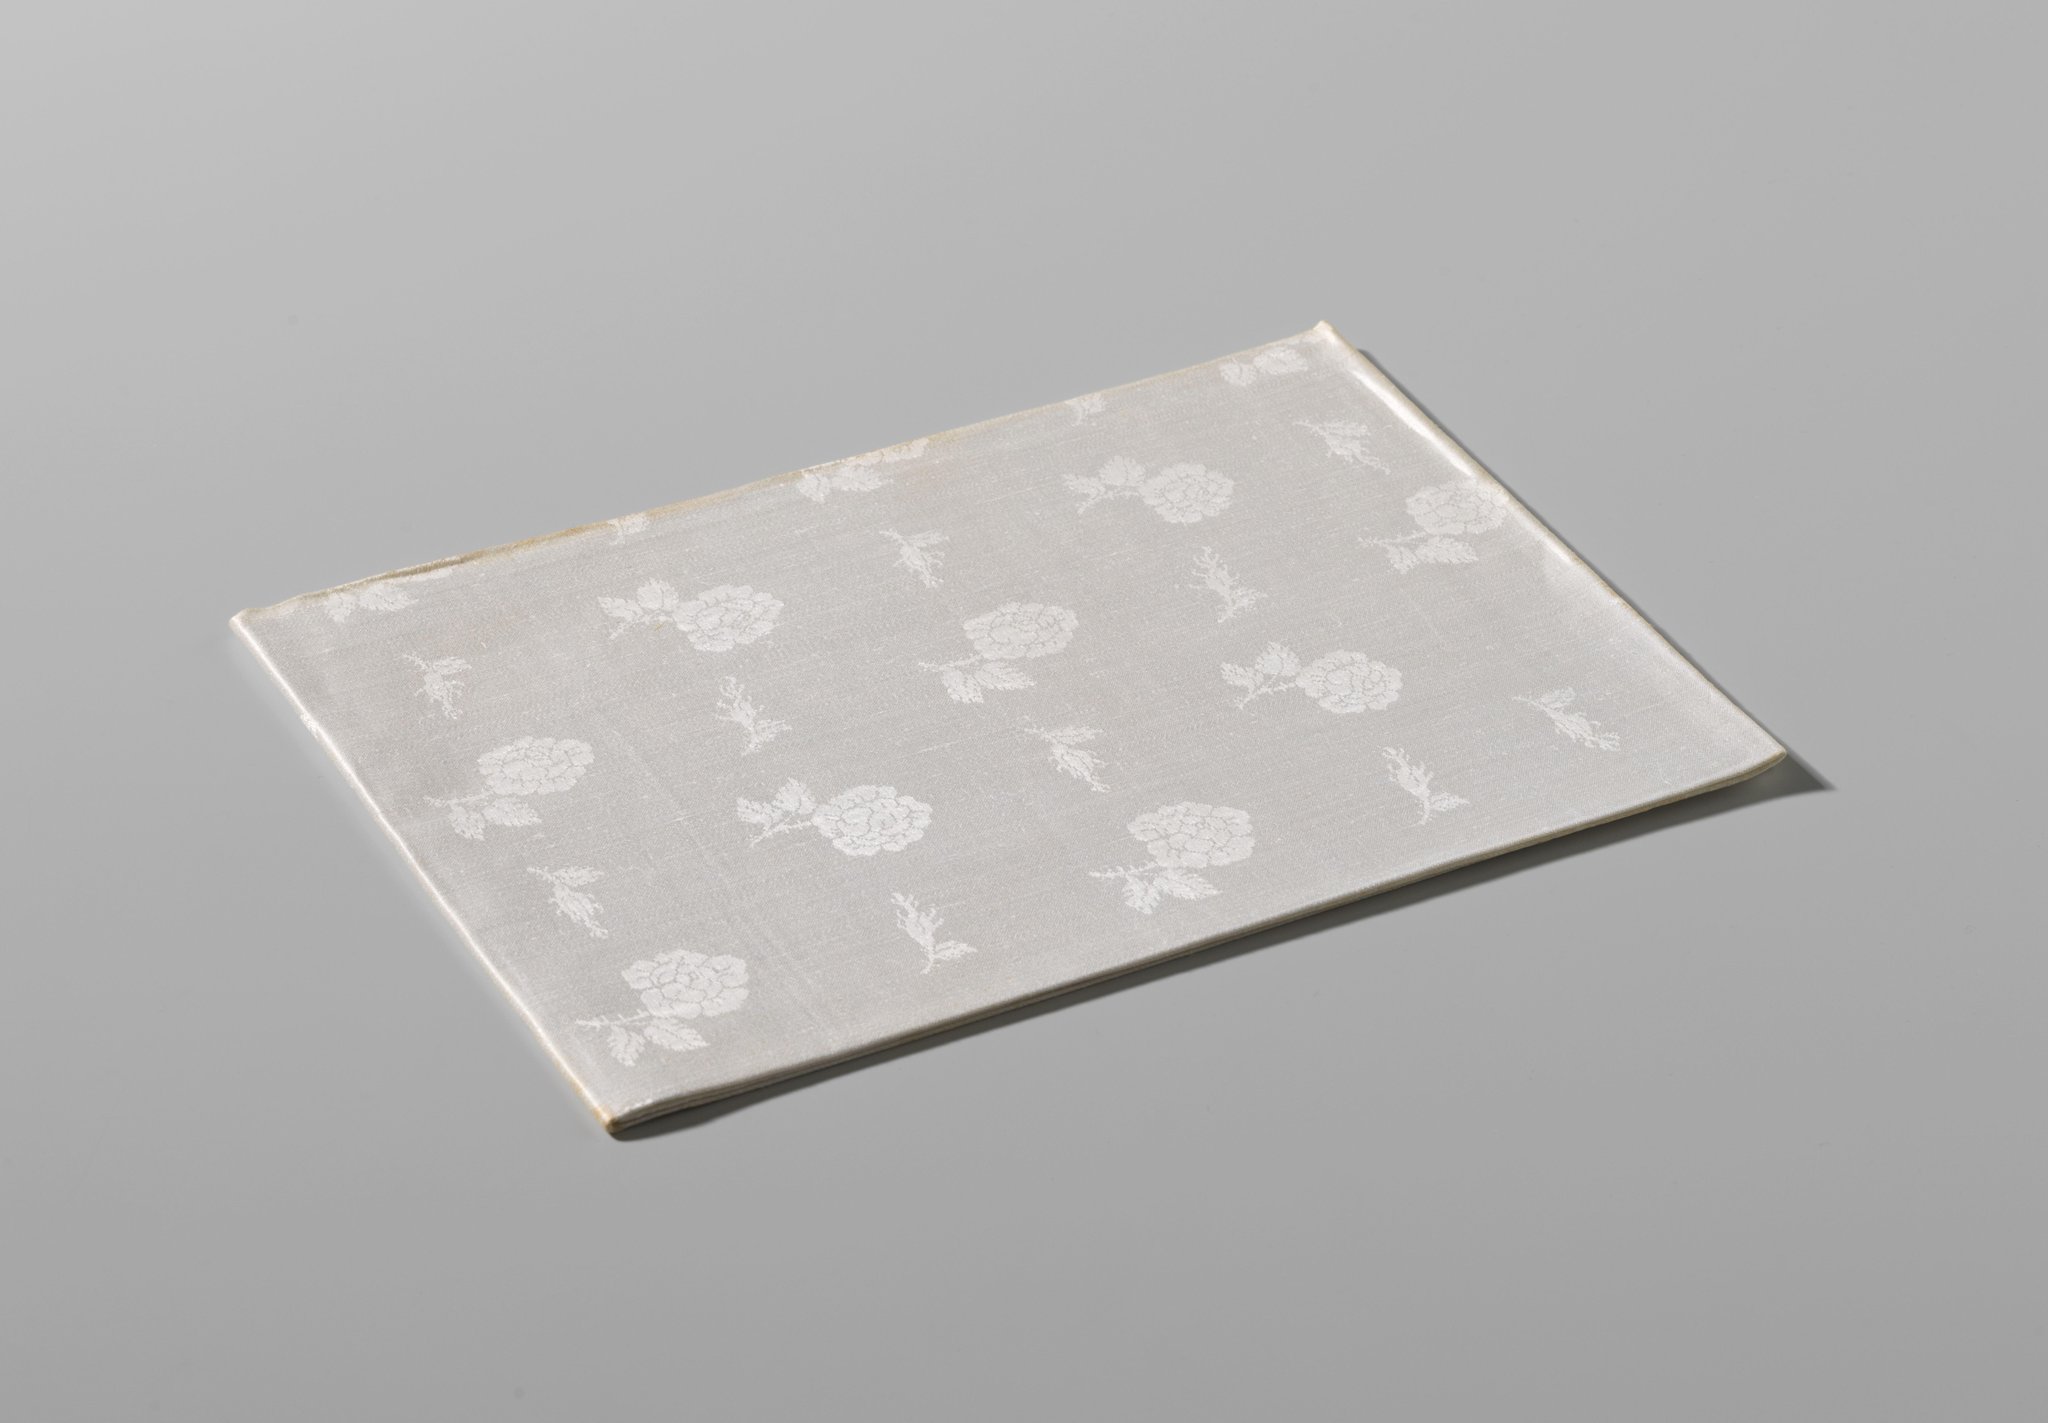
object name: napkin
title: Servet van wit linnendamast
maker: Anonymous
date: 1770-1795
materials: linen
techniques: damask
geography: germany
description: Wit linnen damasten servet met een patroon roosjes en rozenknoppen met een rand van rozetakken en een bloemboeket in de hoeken. Merk BSG en 42.